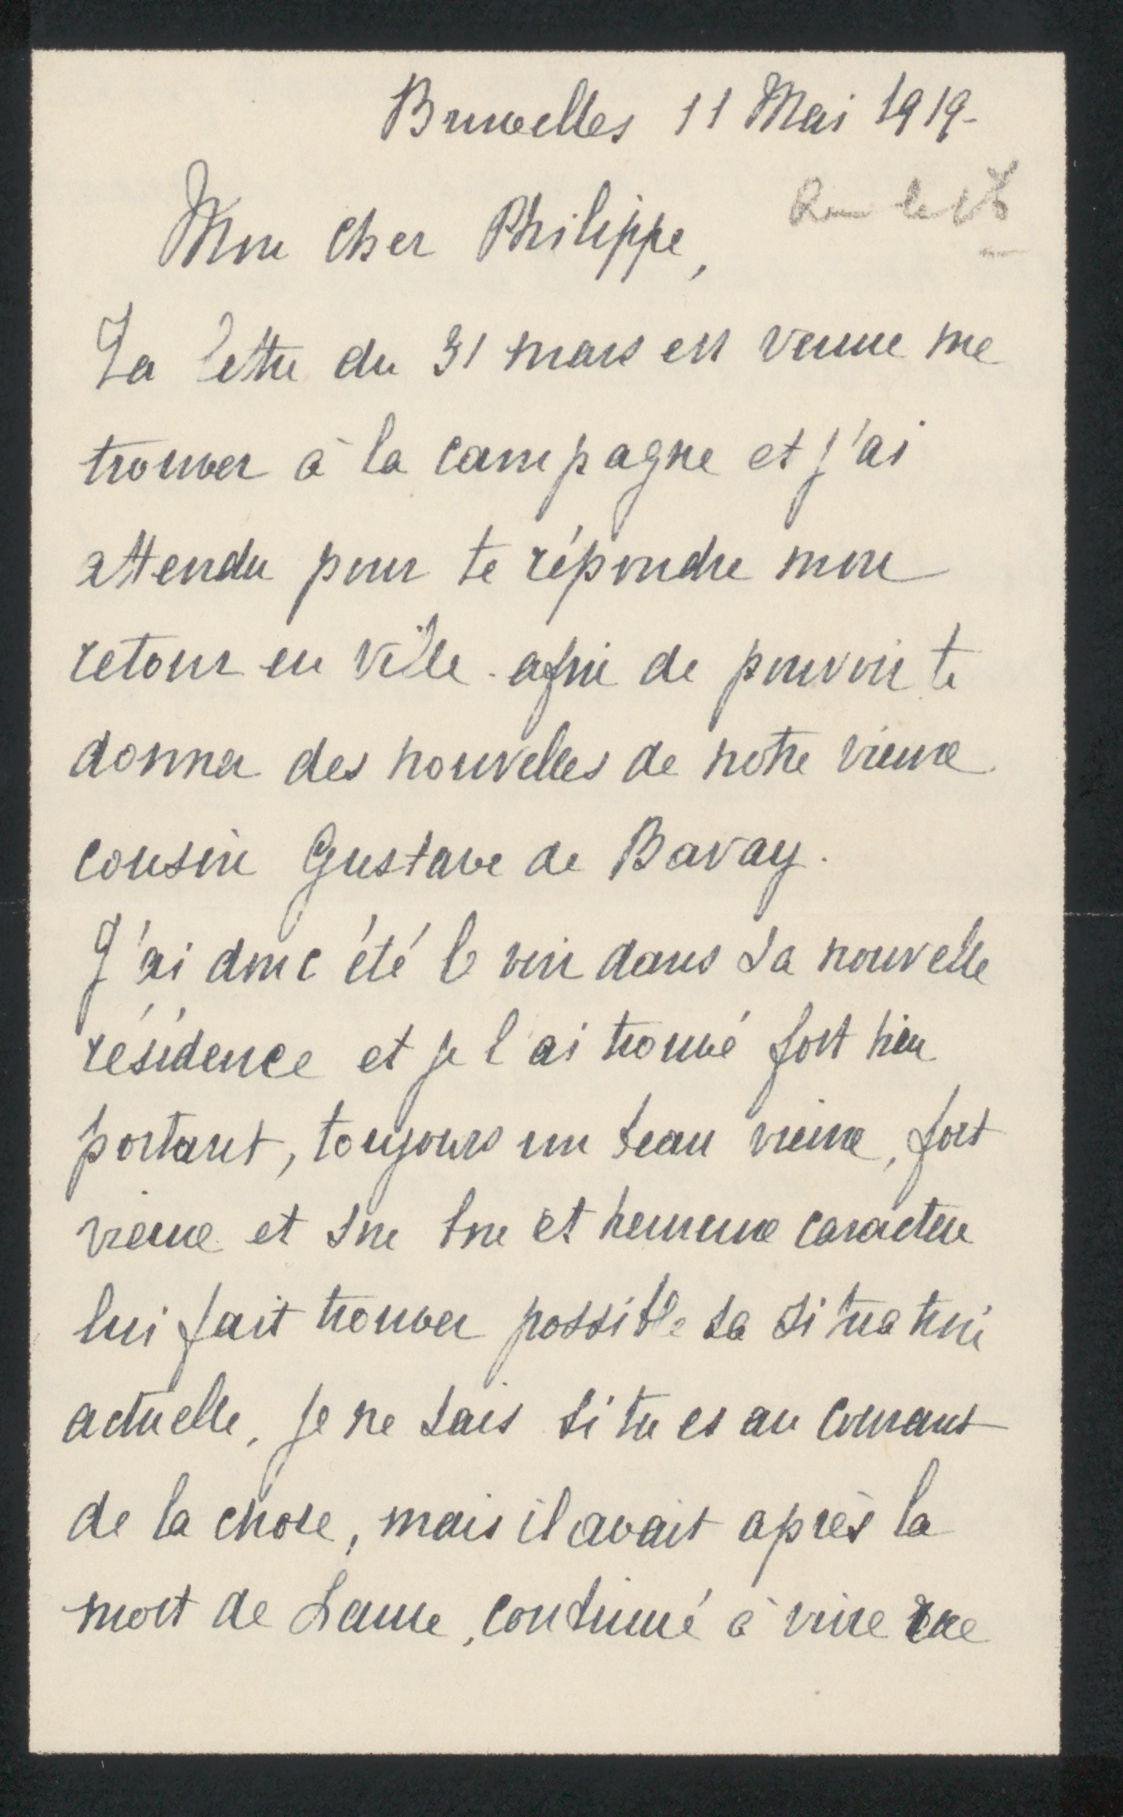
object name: letter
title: Brief aan Philip Zilcken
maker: marguerite stevens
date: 1919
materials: ink, paper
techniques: pen, writing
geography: brussels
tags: the hague, painter, draughtsman, philip zilcken, family life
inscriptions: collector's mark: ‘RPK’, watermark